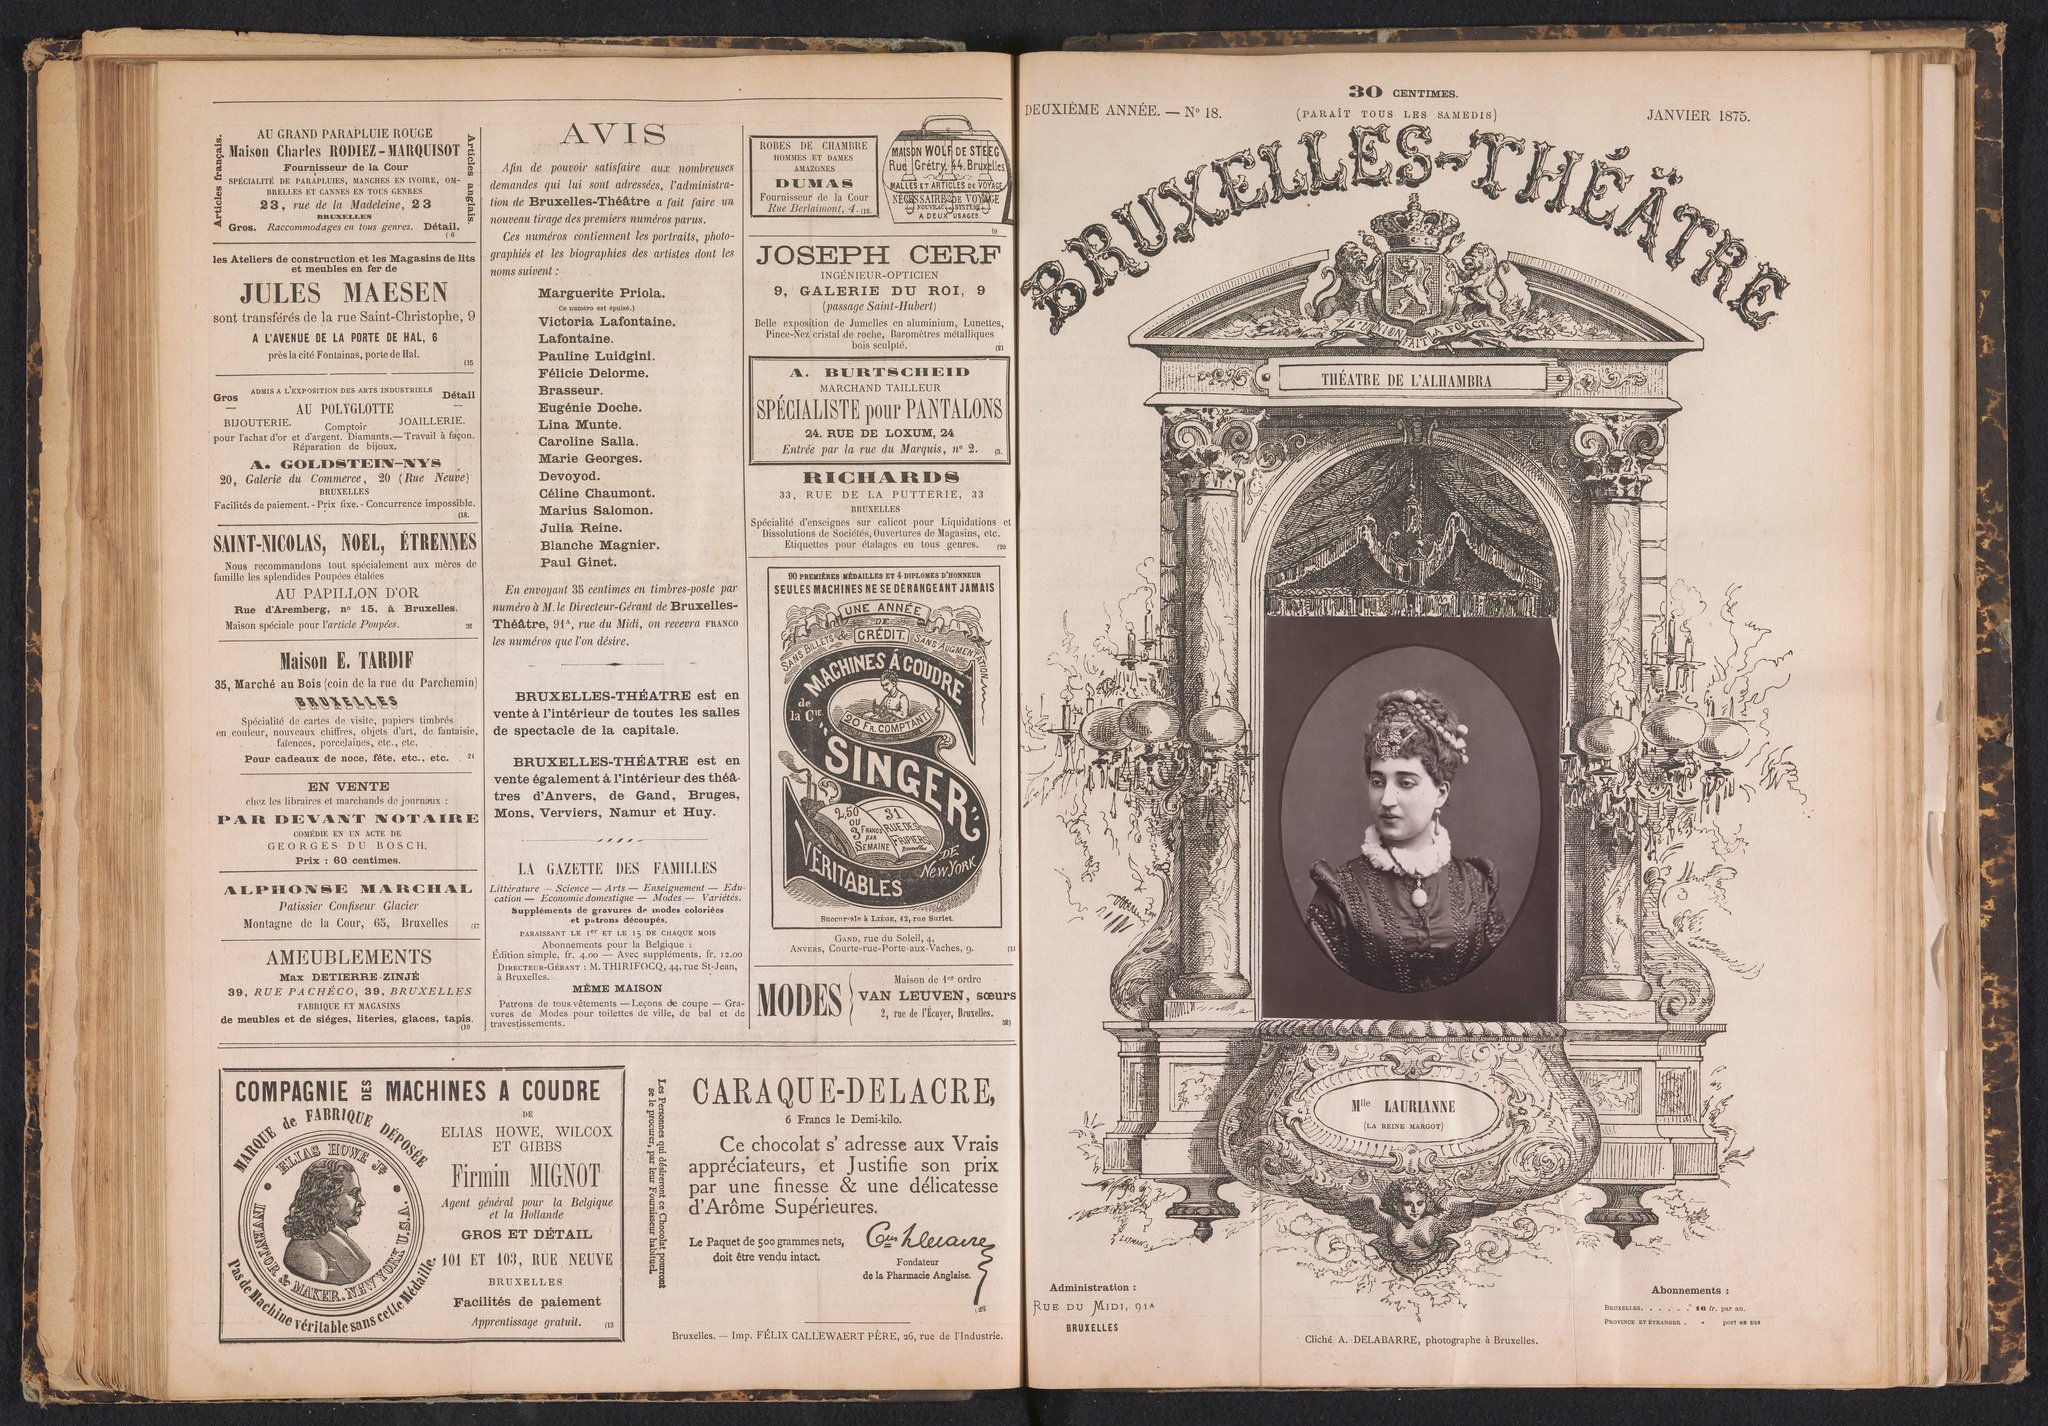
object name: page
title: Mlle Laurianne (La reine Margot)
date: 1869-1874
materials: paper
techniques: woodburytype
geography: brussels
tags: portrait of opera-singer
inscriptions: number: ‘No 18.’